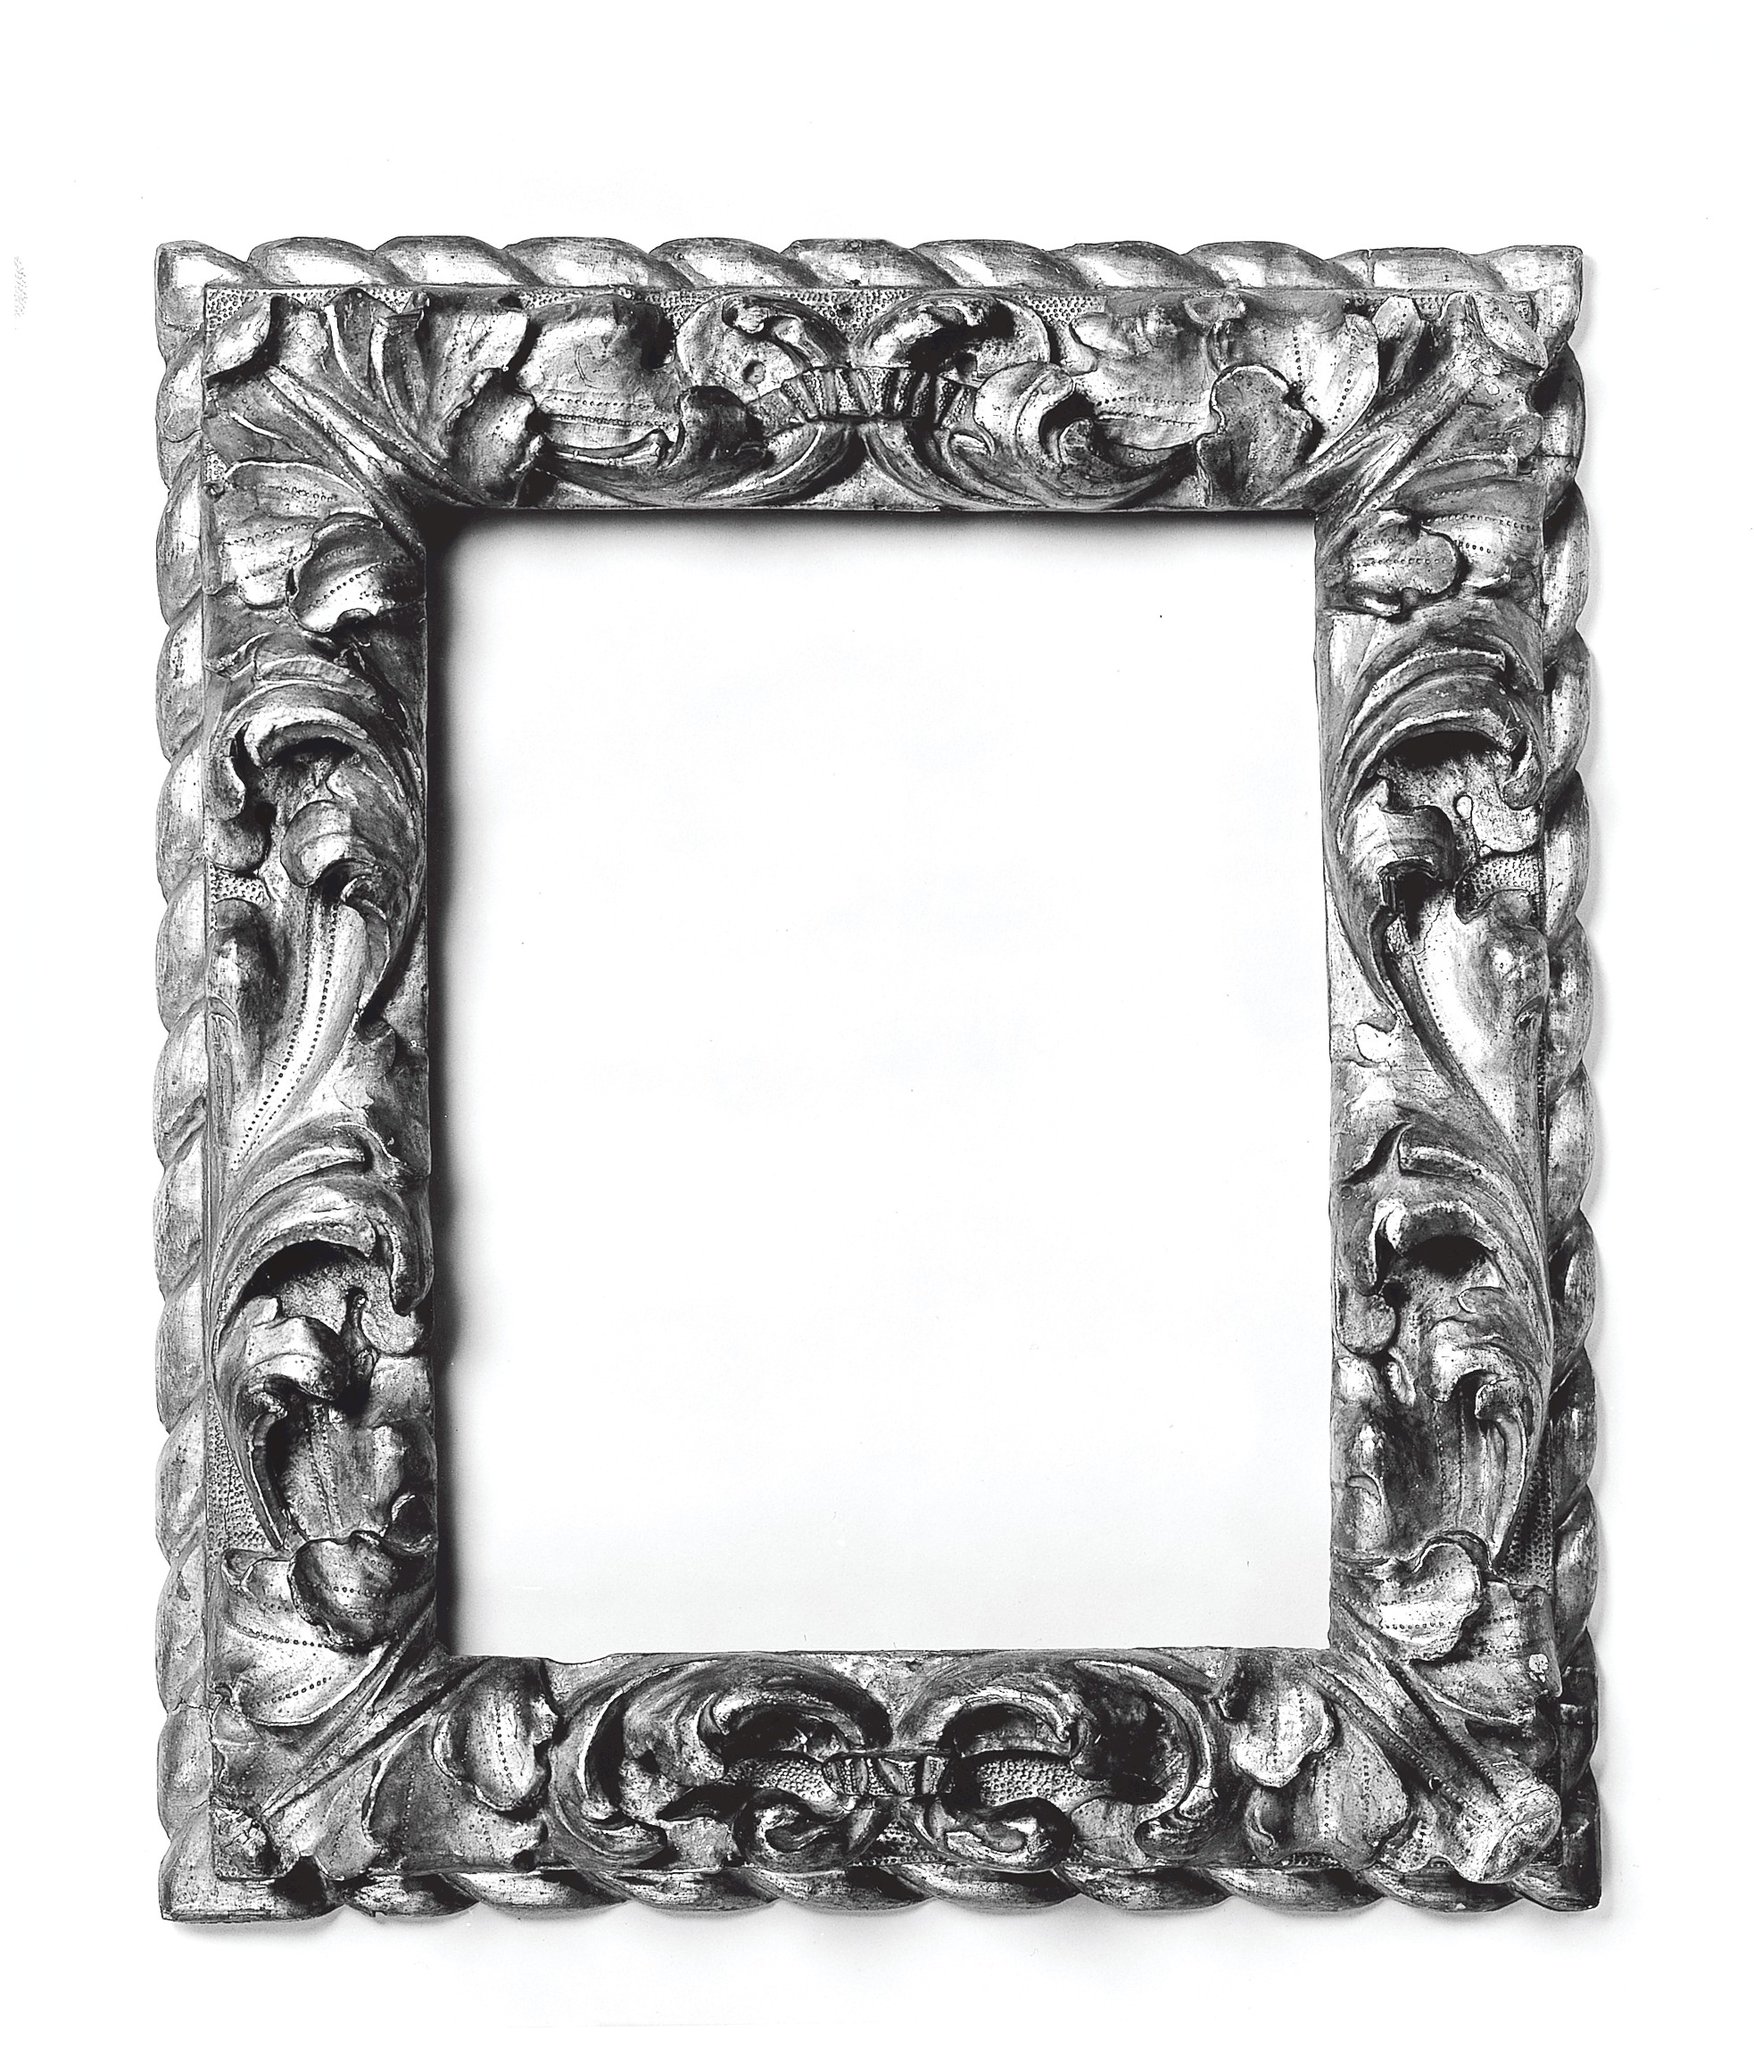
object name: frame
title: Astragal frame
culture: spanish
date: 1701-1733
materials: wood